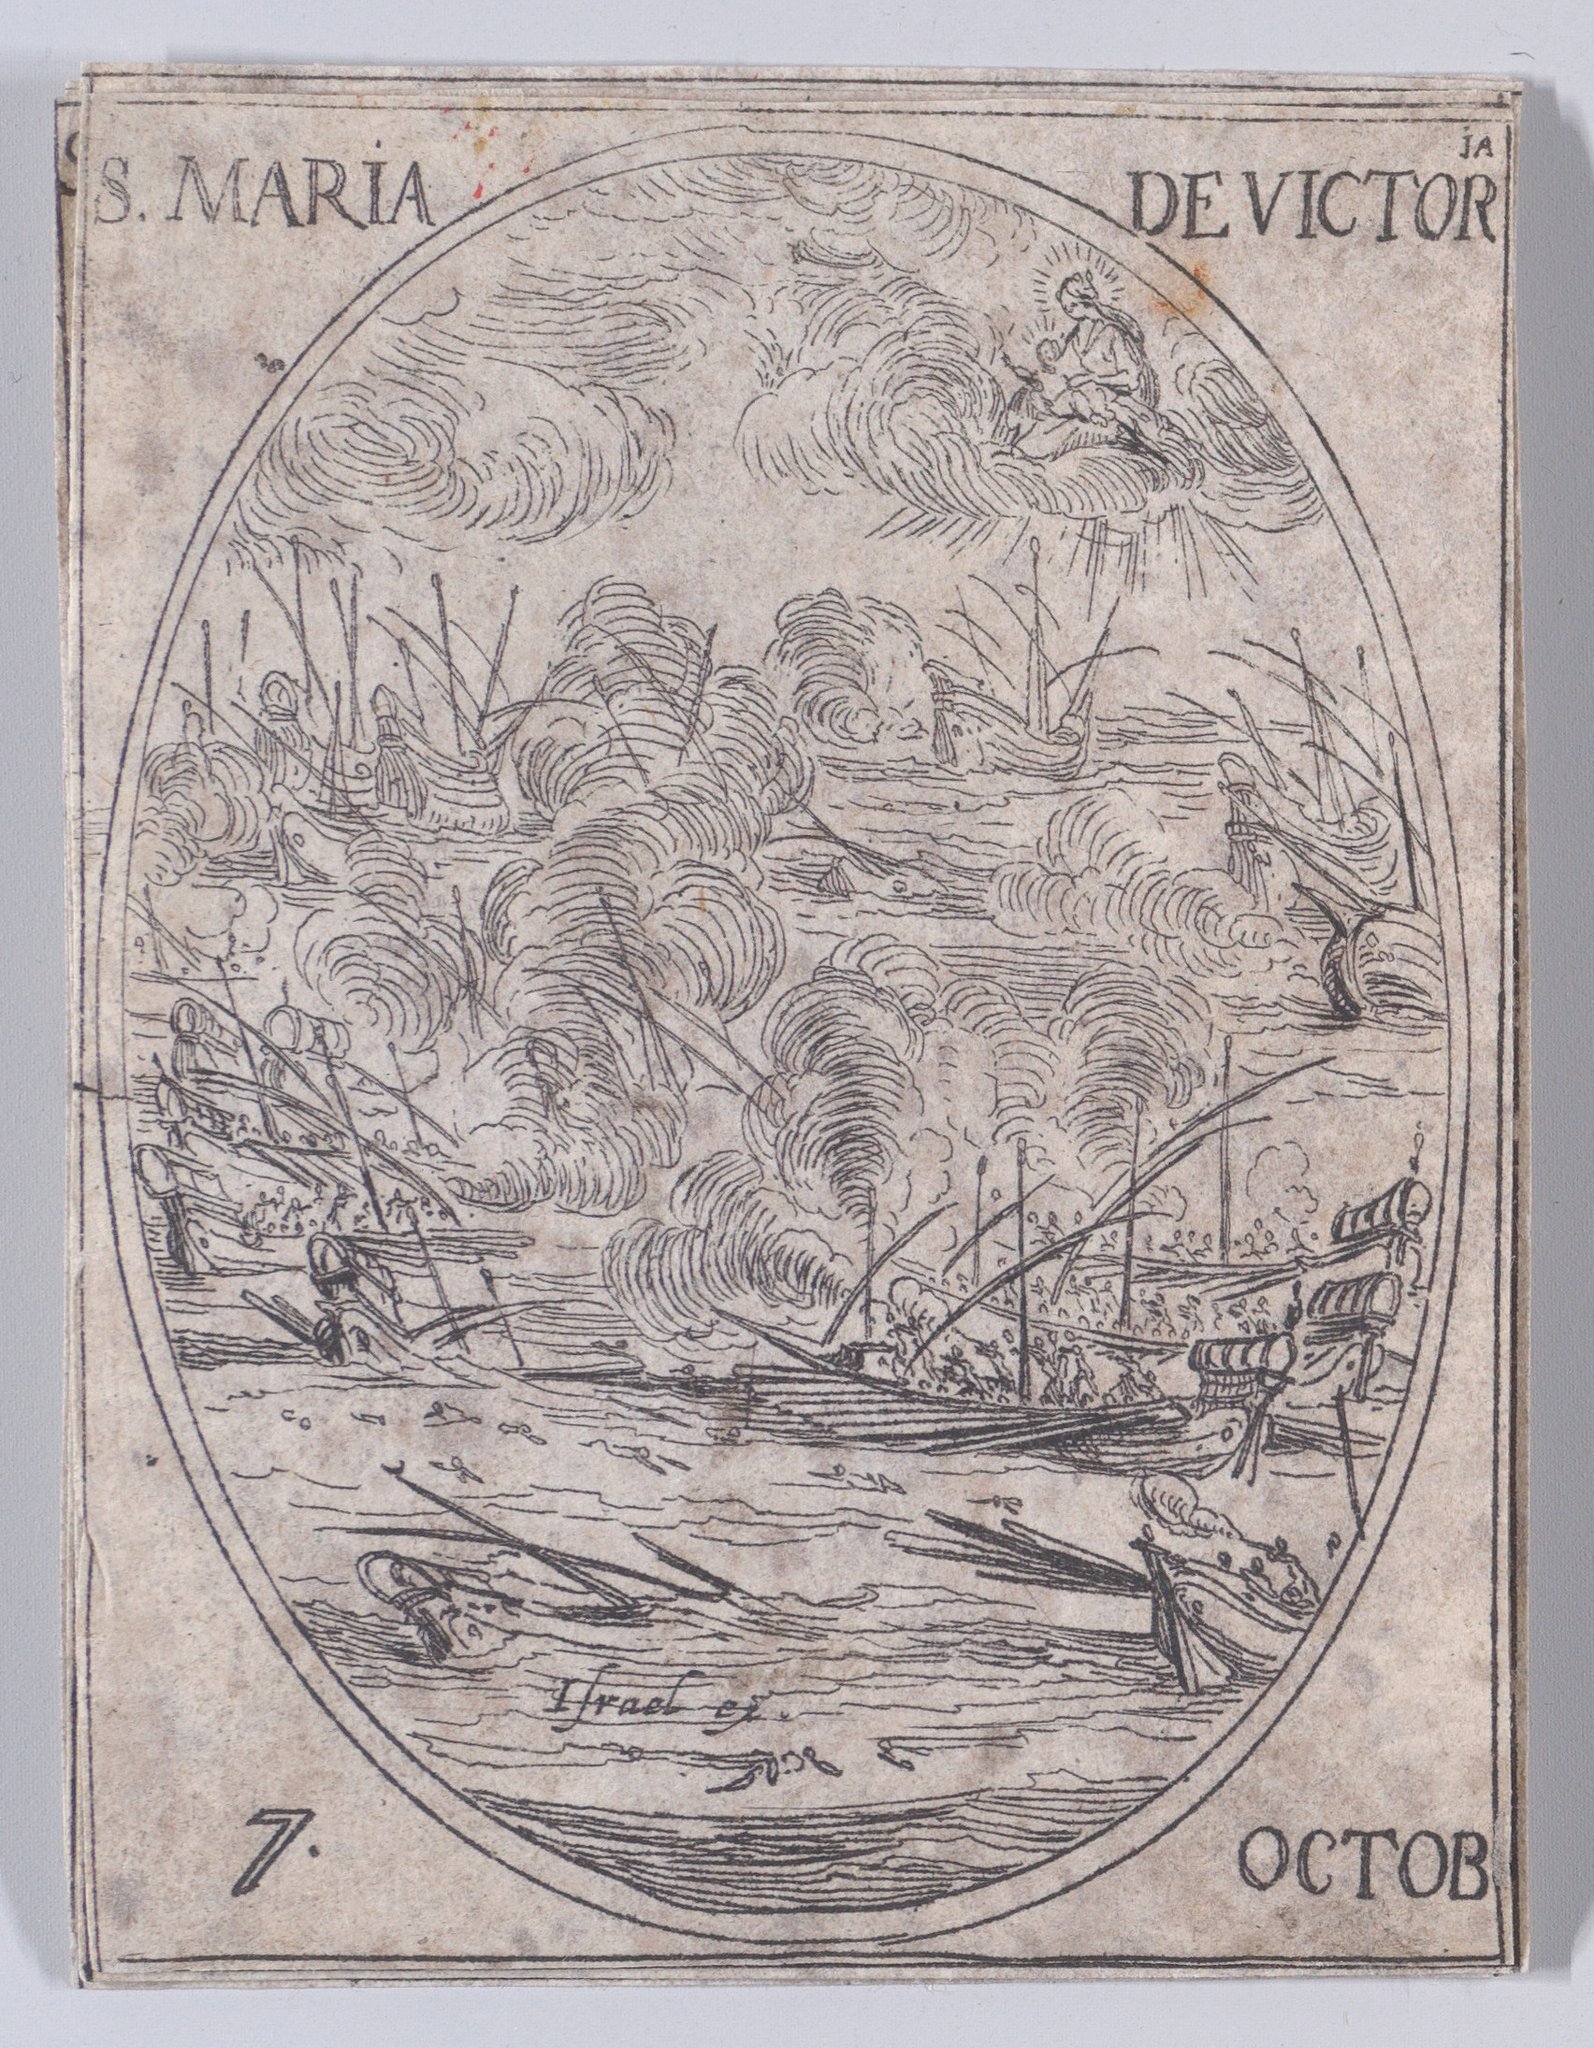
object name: print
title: Ste. Marie des Victoires (St. Mary of Victories), October 7th, from "Les Images De Tous Les Saincts et Saintes de L'Année" (Images of All of the Saints and Religious Events of the Year)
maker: jacques callot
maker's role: artist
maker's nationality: french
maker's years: 1592-1635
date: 1636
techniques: etching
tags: boats